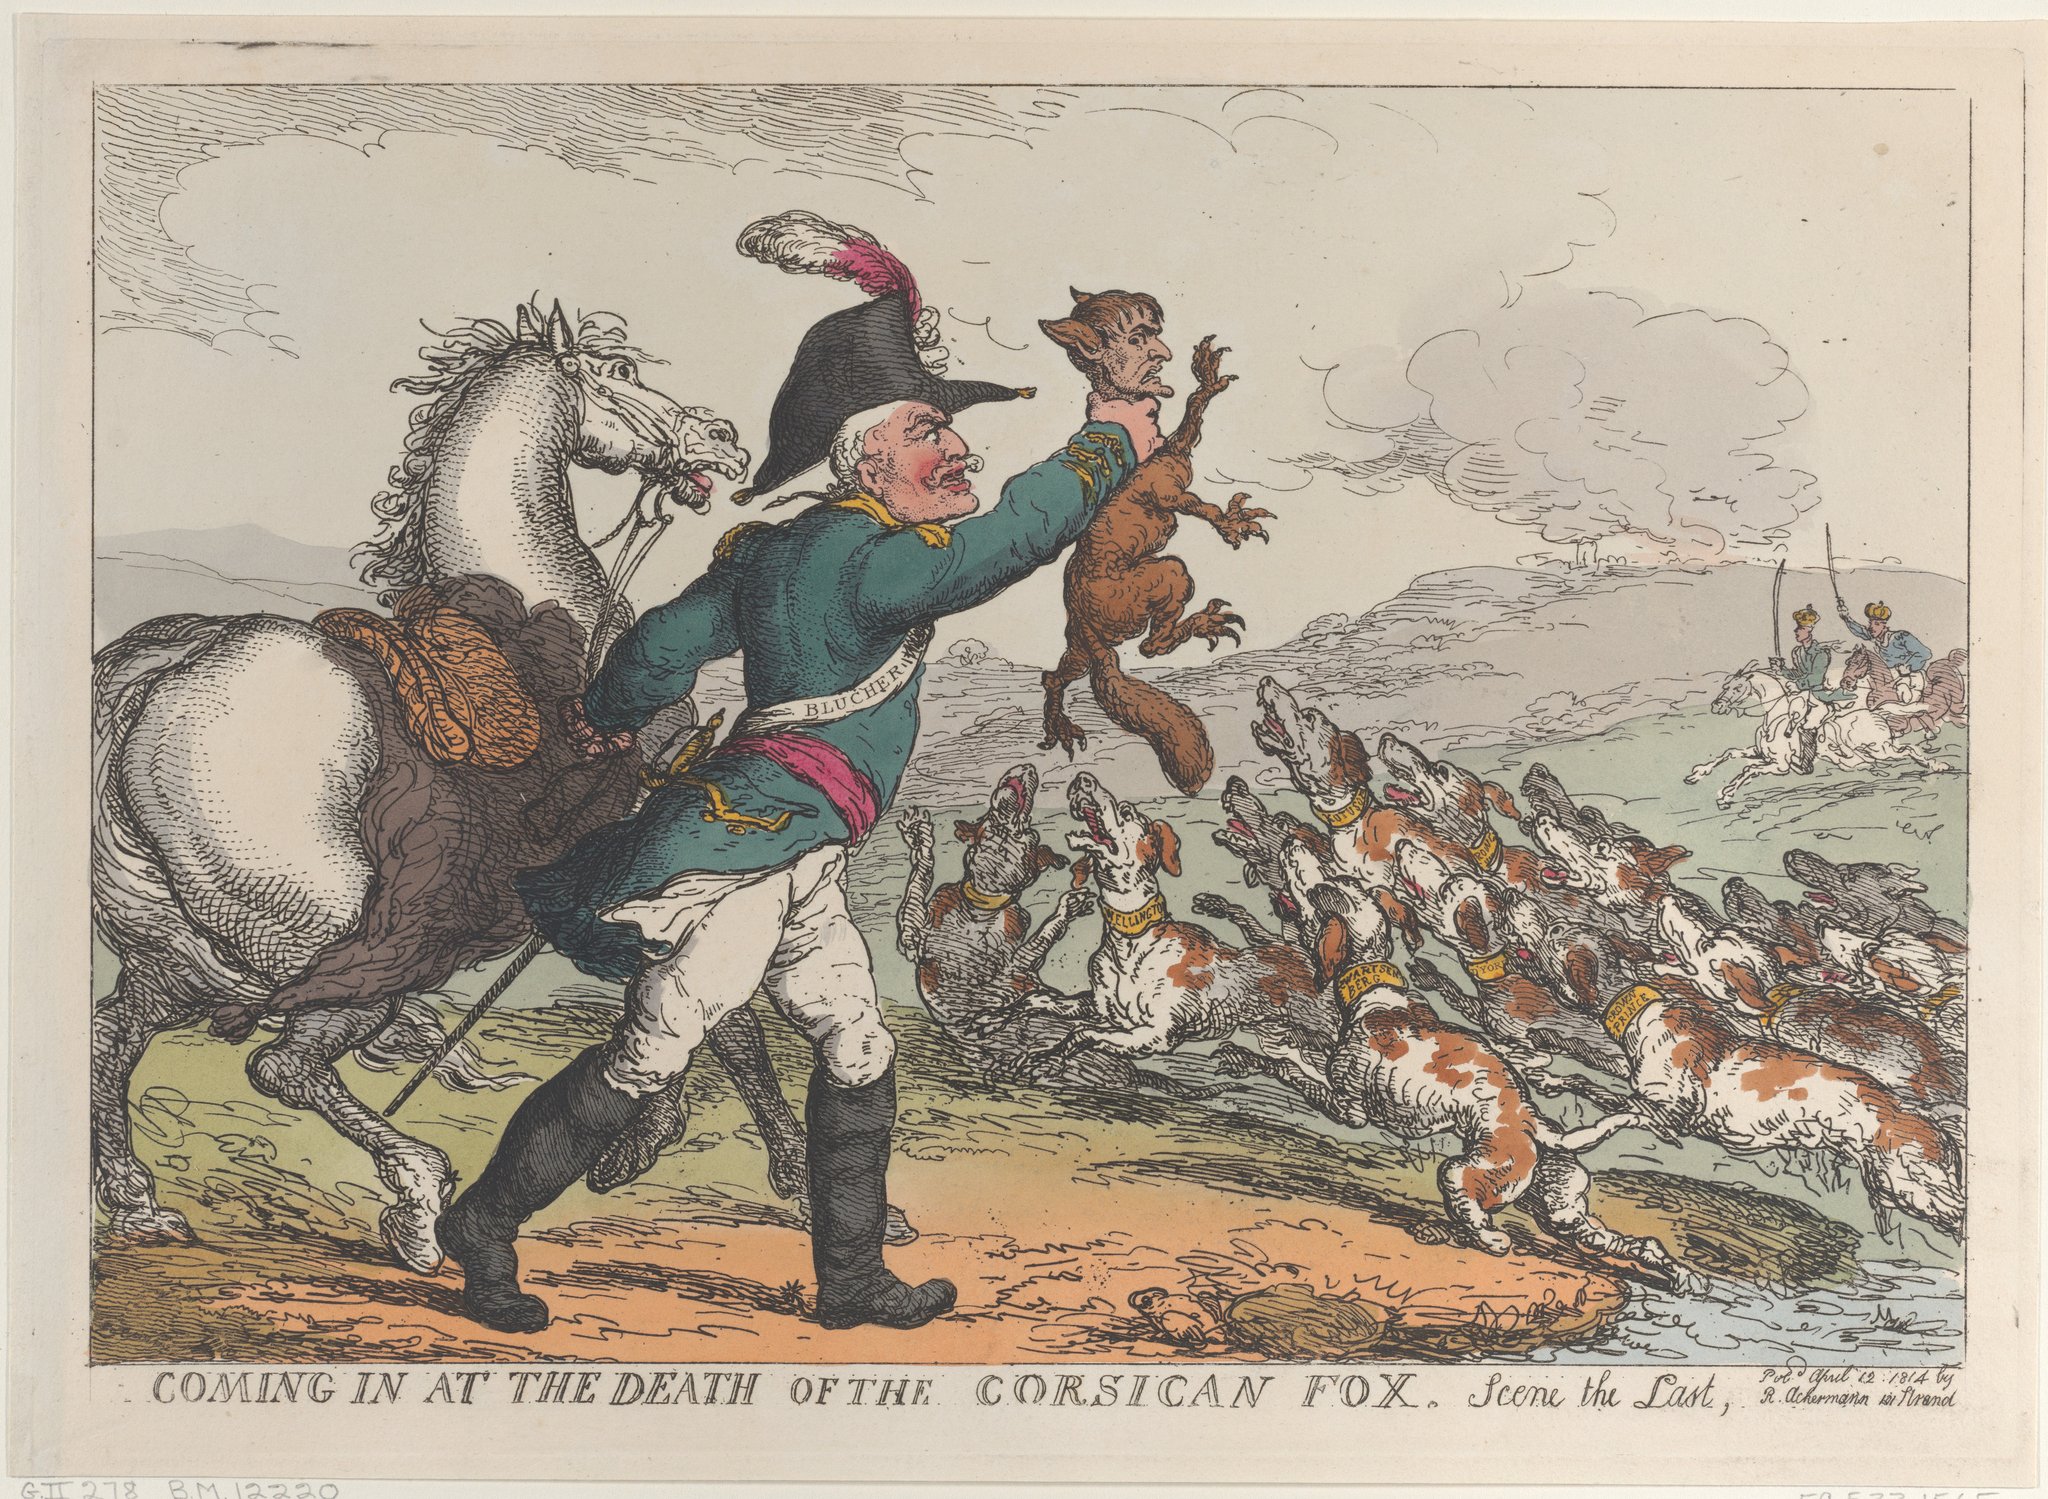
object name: print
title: Coming in at the Death of the Corsican Fox, Scene the Last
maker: thomas rowlandson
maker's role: artist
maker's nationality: british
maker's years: 1757-1827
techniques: etching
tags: satire,napoleon i,men,dogs,horses,politics